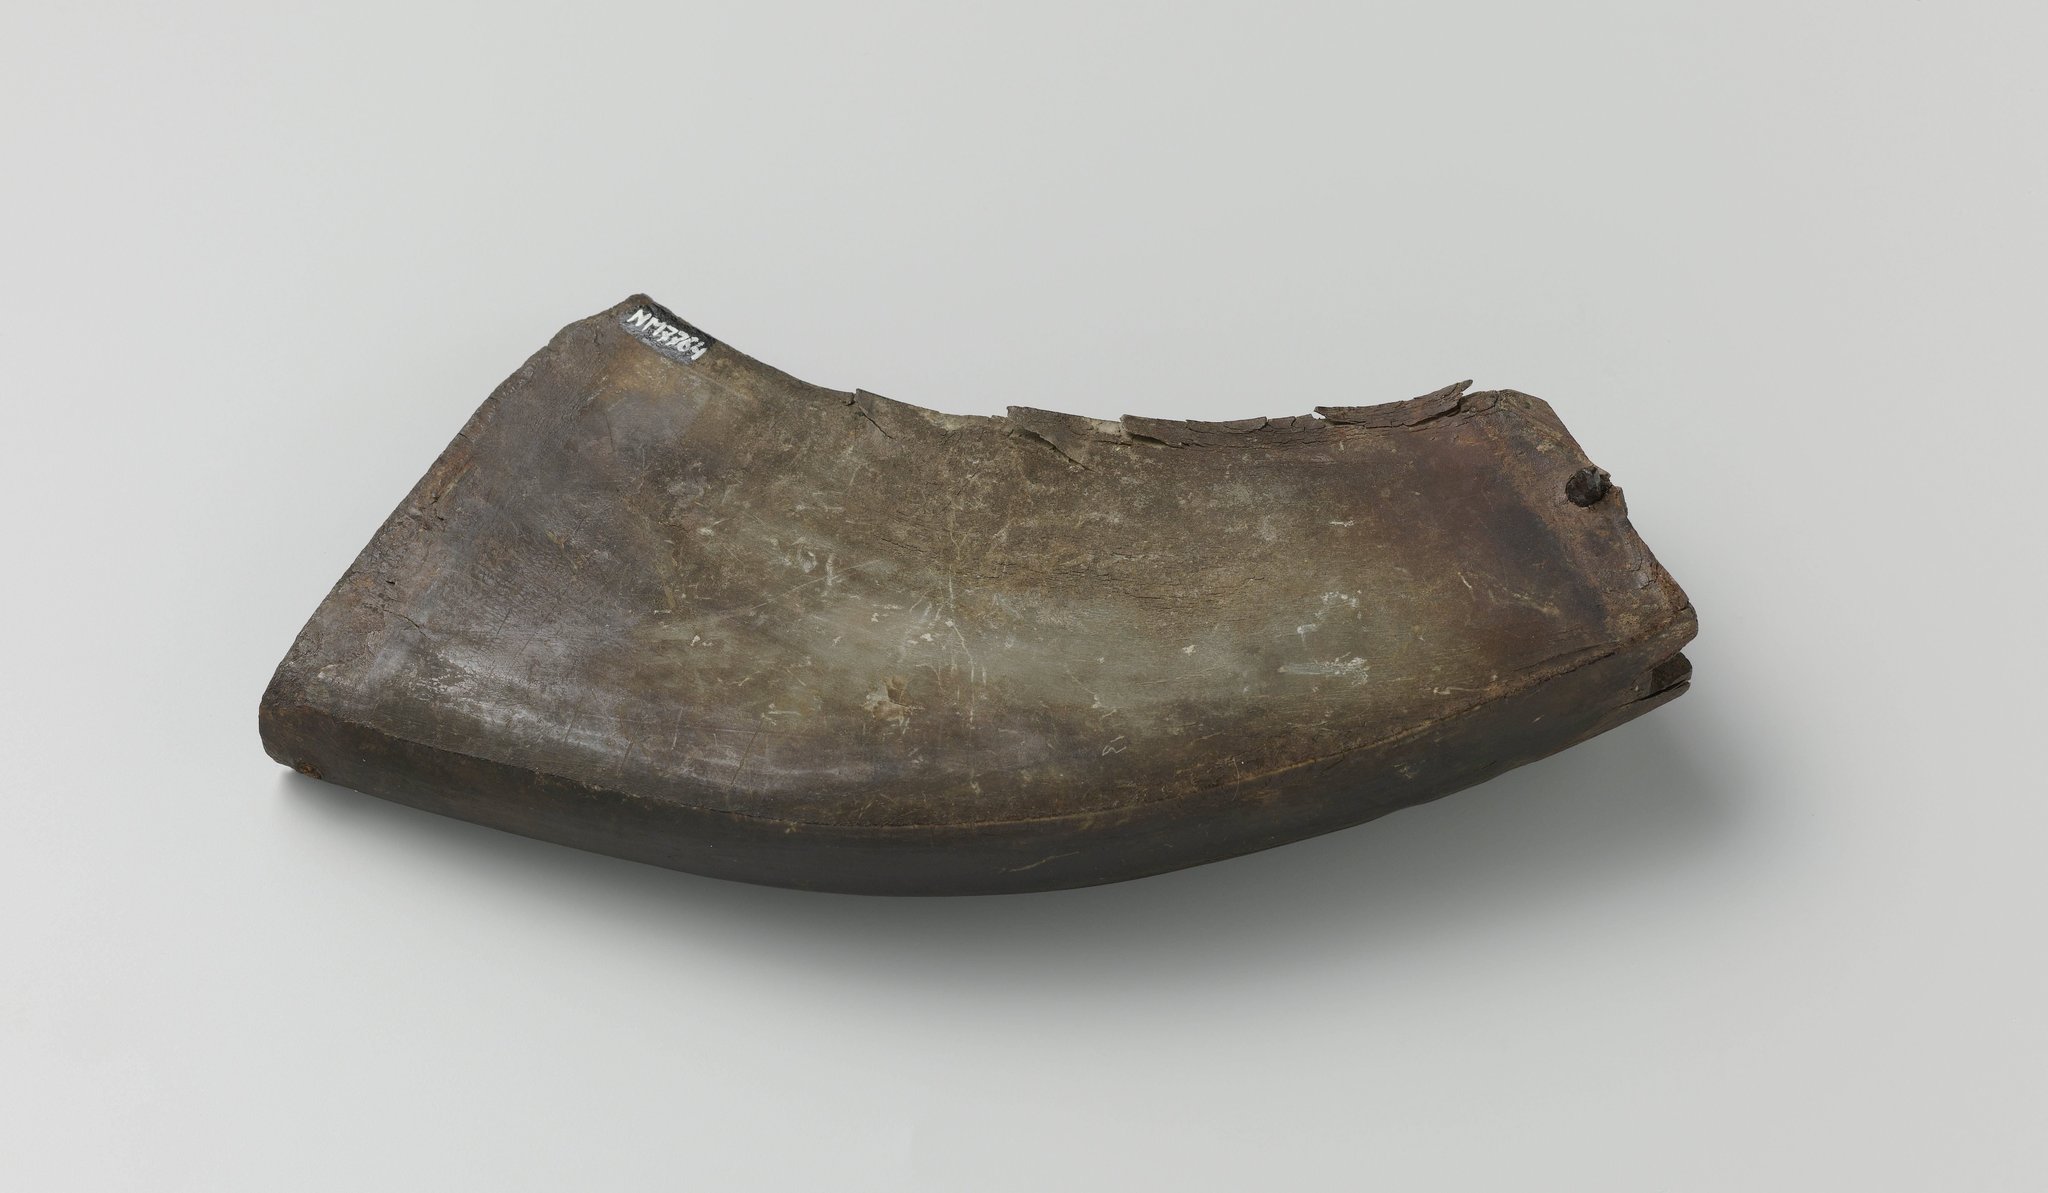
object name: powder horn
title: Clock and gunpowder horn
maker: Anonymous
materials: copper, horn, iron, wood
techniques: cutting, forging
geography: netherlands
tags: willem barendsz., amsterdam, jacob van heemskerck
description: This clock was originally intended as merchandise for sale or as a gift. It was hung up in the ‘Save House’ as the only means of providing a sense of time during the long, polar nights. On 3 December 1596, it froze. Barentsz and Van Heemskerck shoved a parting letter into the gunpowder horn when they left. Three centuries later, the horn was rediscovered with the letter still inside. The letter cannot be exhibited due to its fragility.